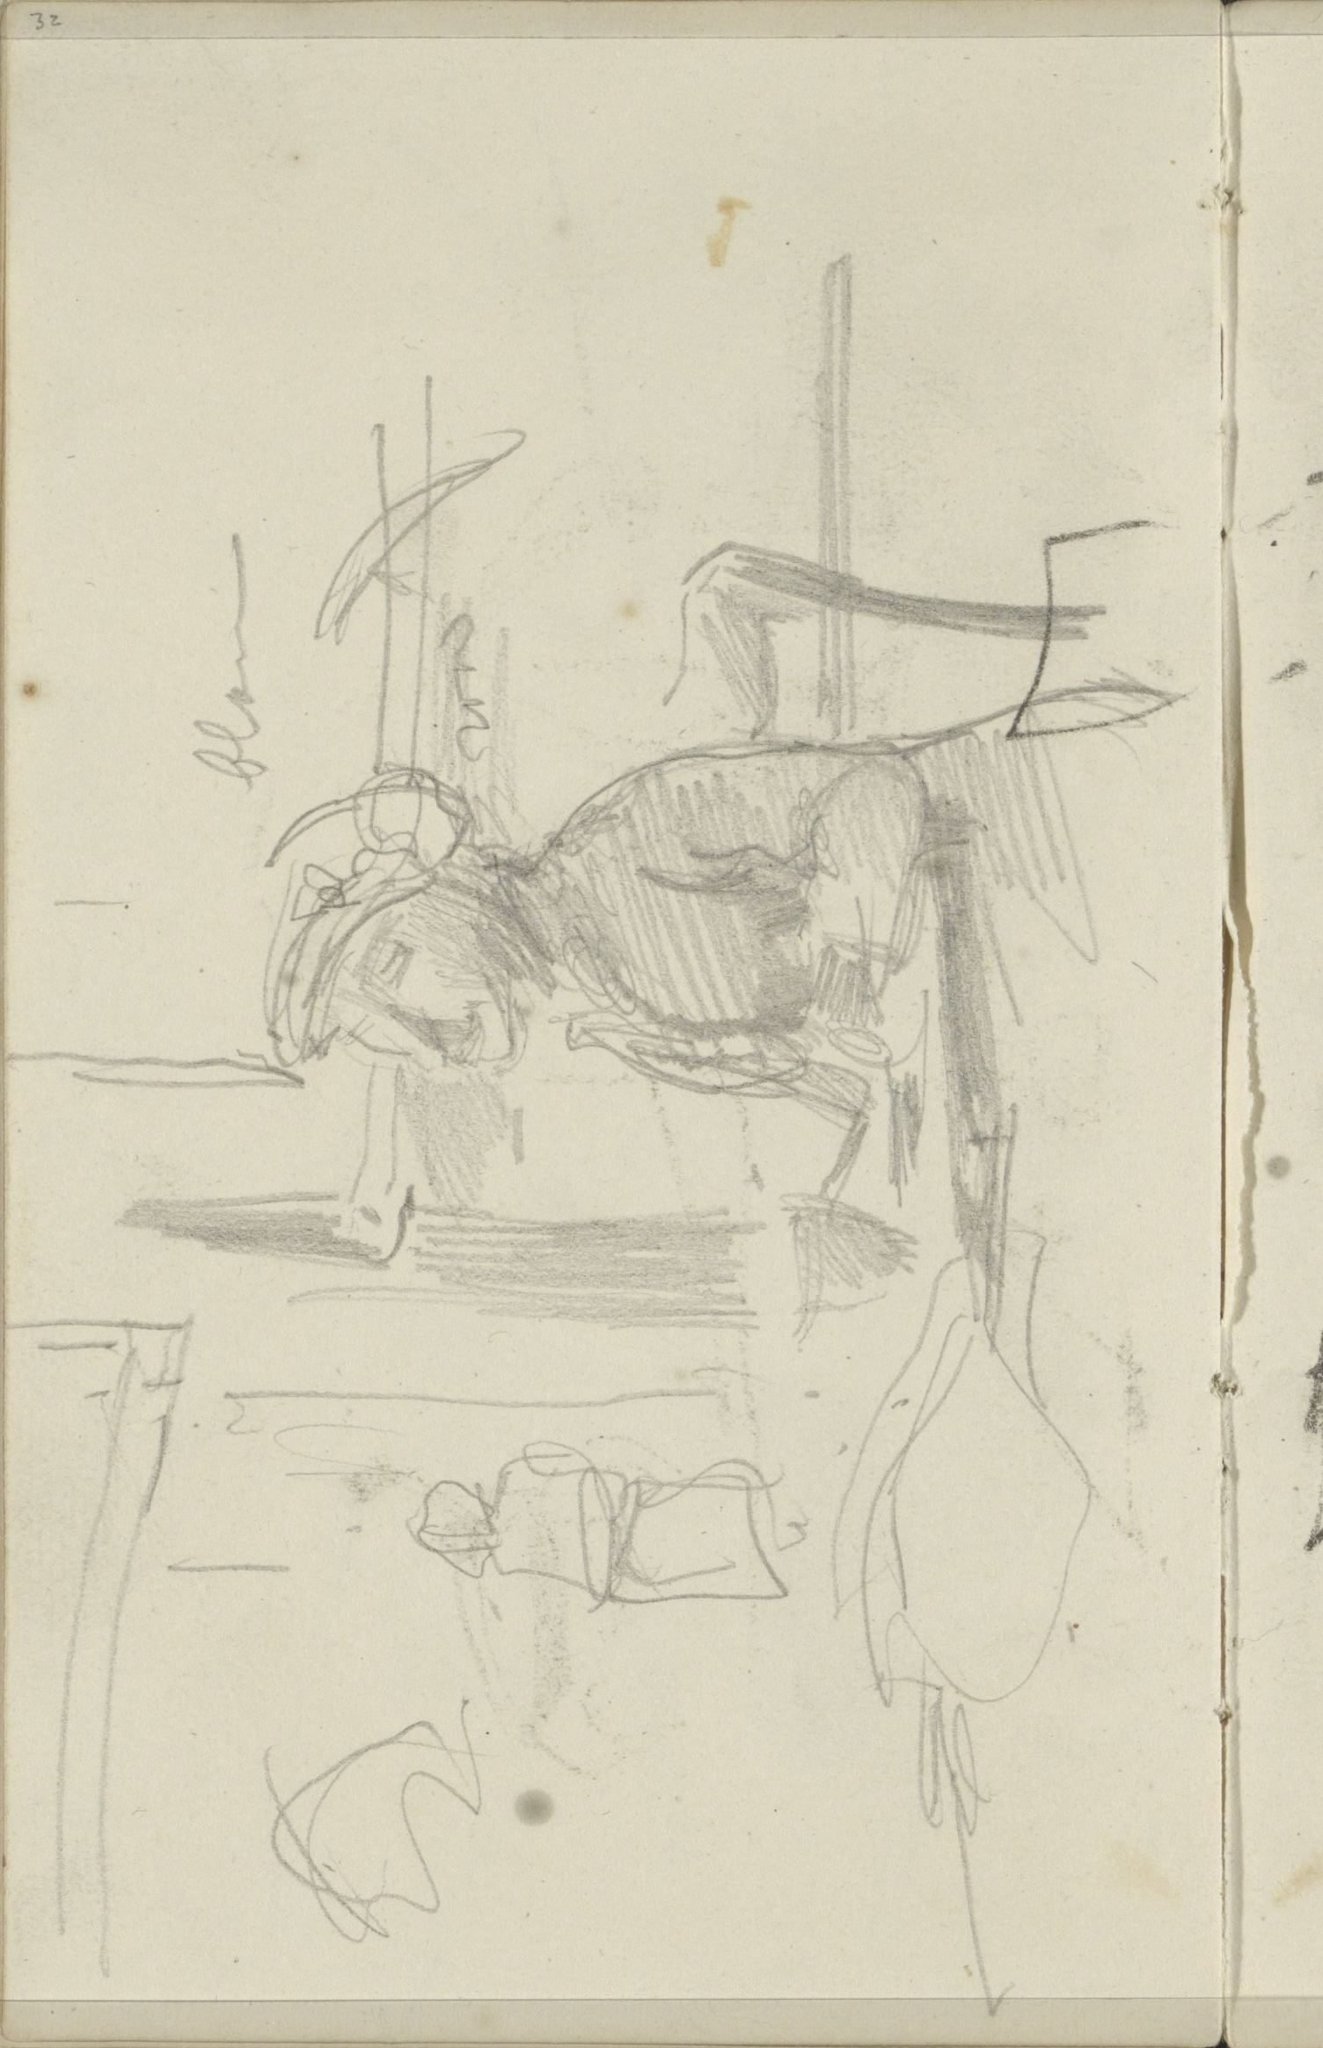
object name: sketchbook leaf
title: Vrouw aan een tafel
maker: george hendrik breitner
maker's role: draughtsman, painter, print maker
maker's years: 1857-1923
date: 1880-1882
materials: paper, pencil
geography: the hague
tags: adult woman, window, sitting figure - aa - female human figure, table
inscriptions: kleurnotitie, handgeschreven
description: Ze zit bij een raam. Pagina 32 uit een schetsboek met 25 bladen.